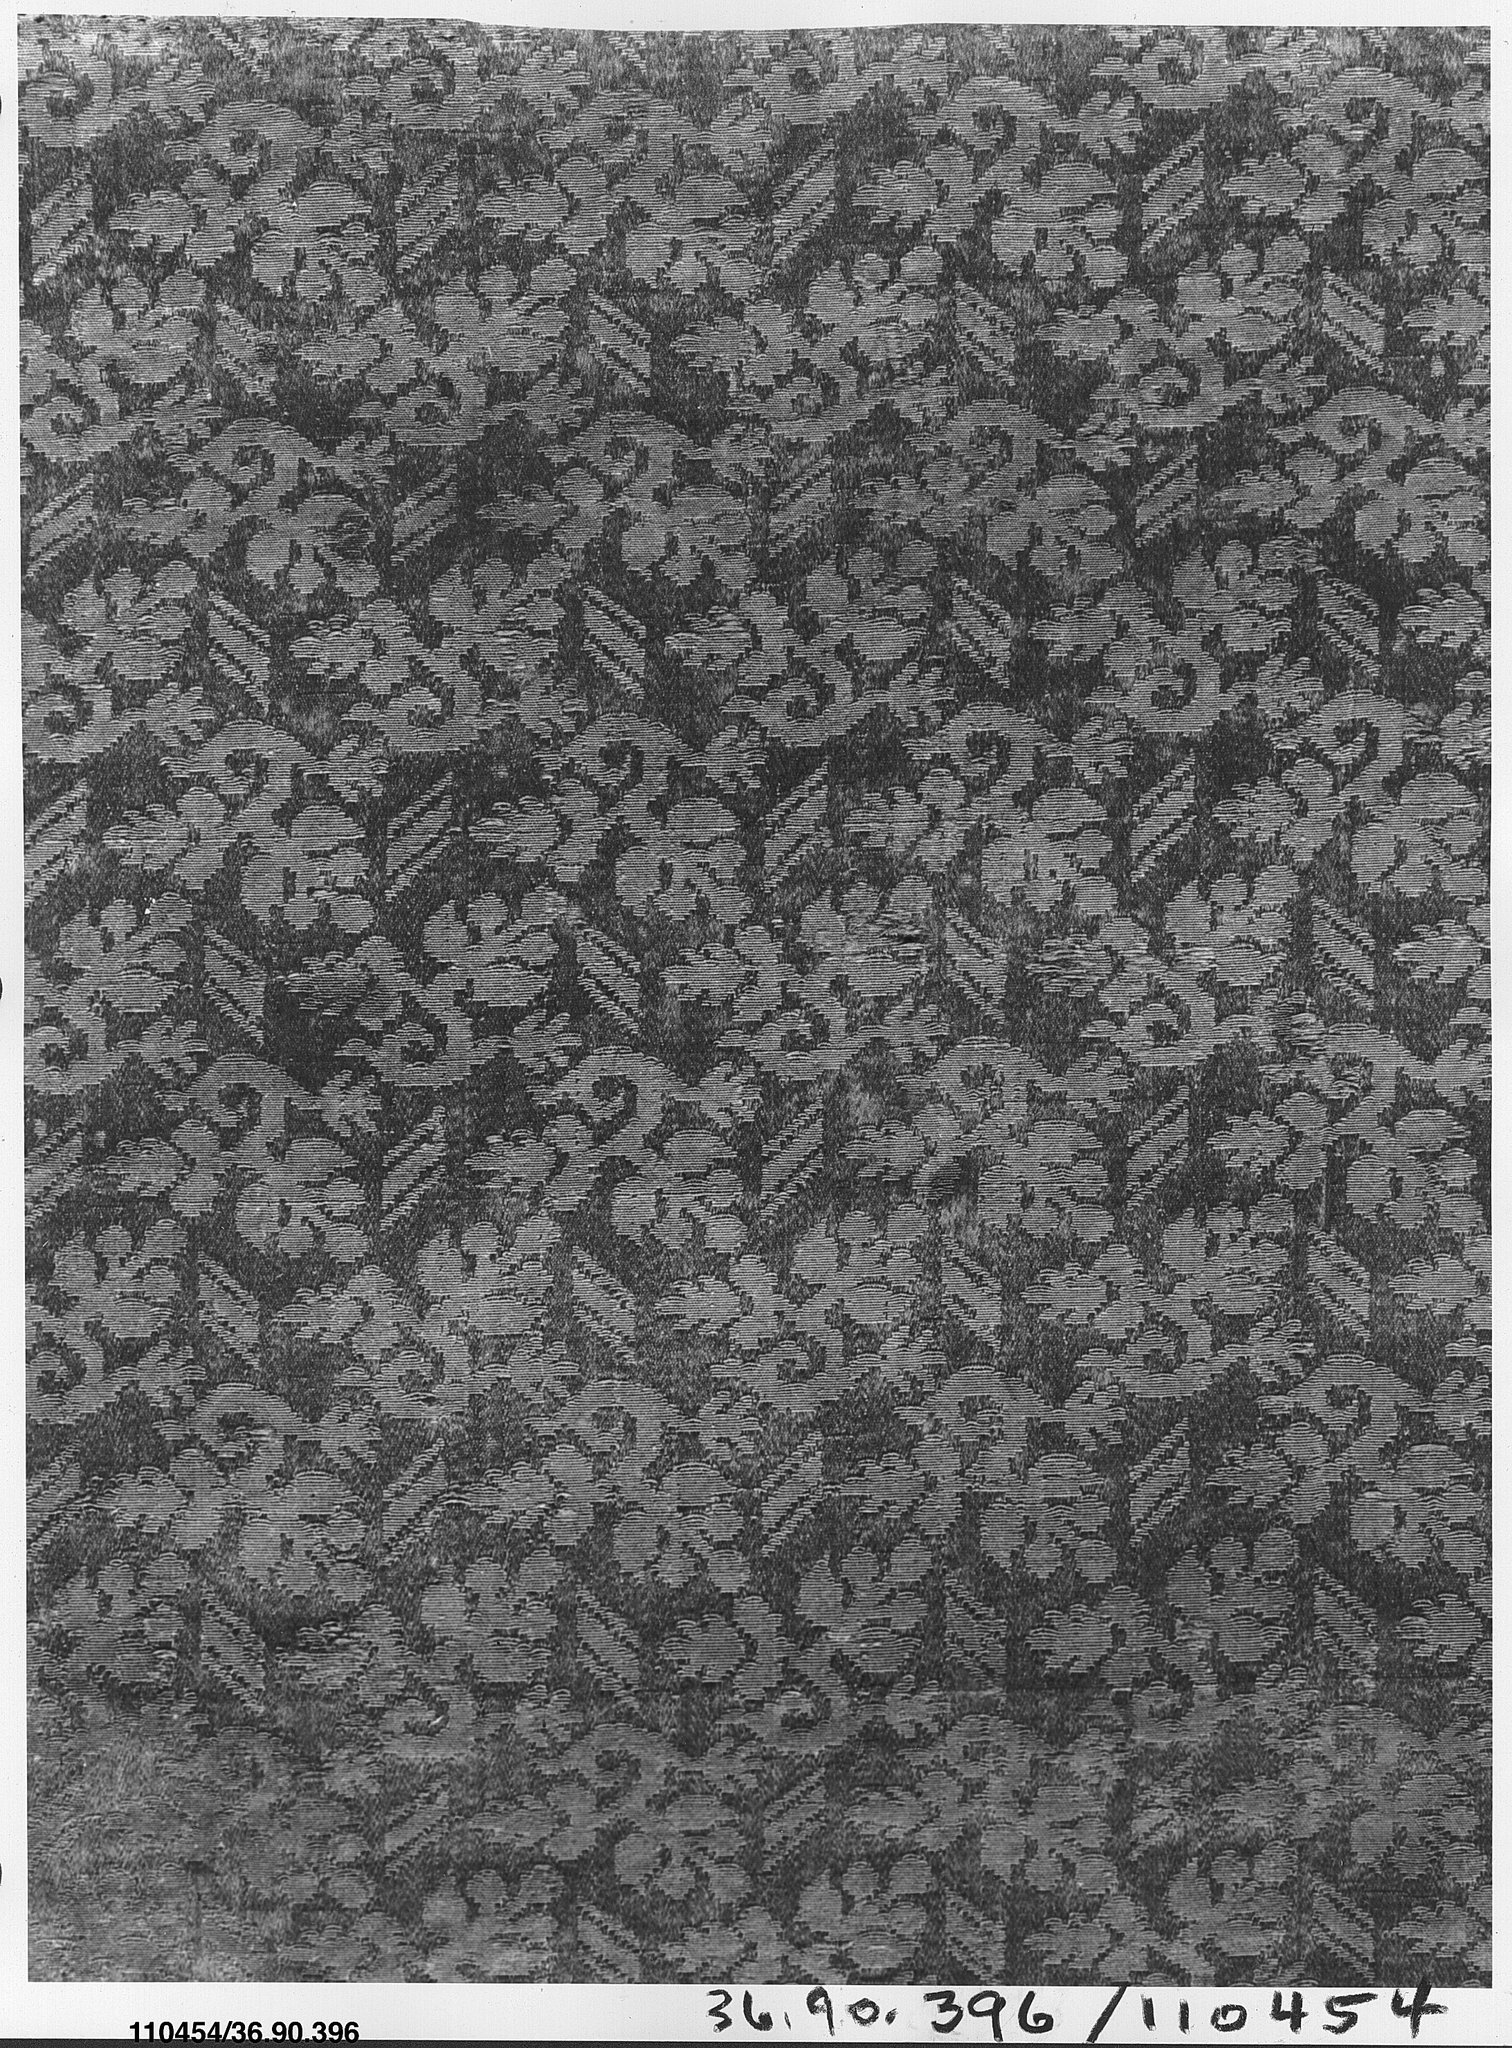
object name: piece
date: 1501-1700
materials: silk